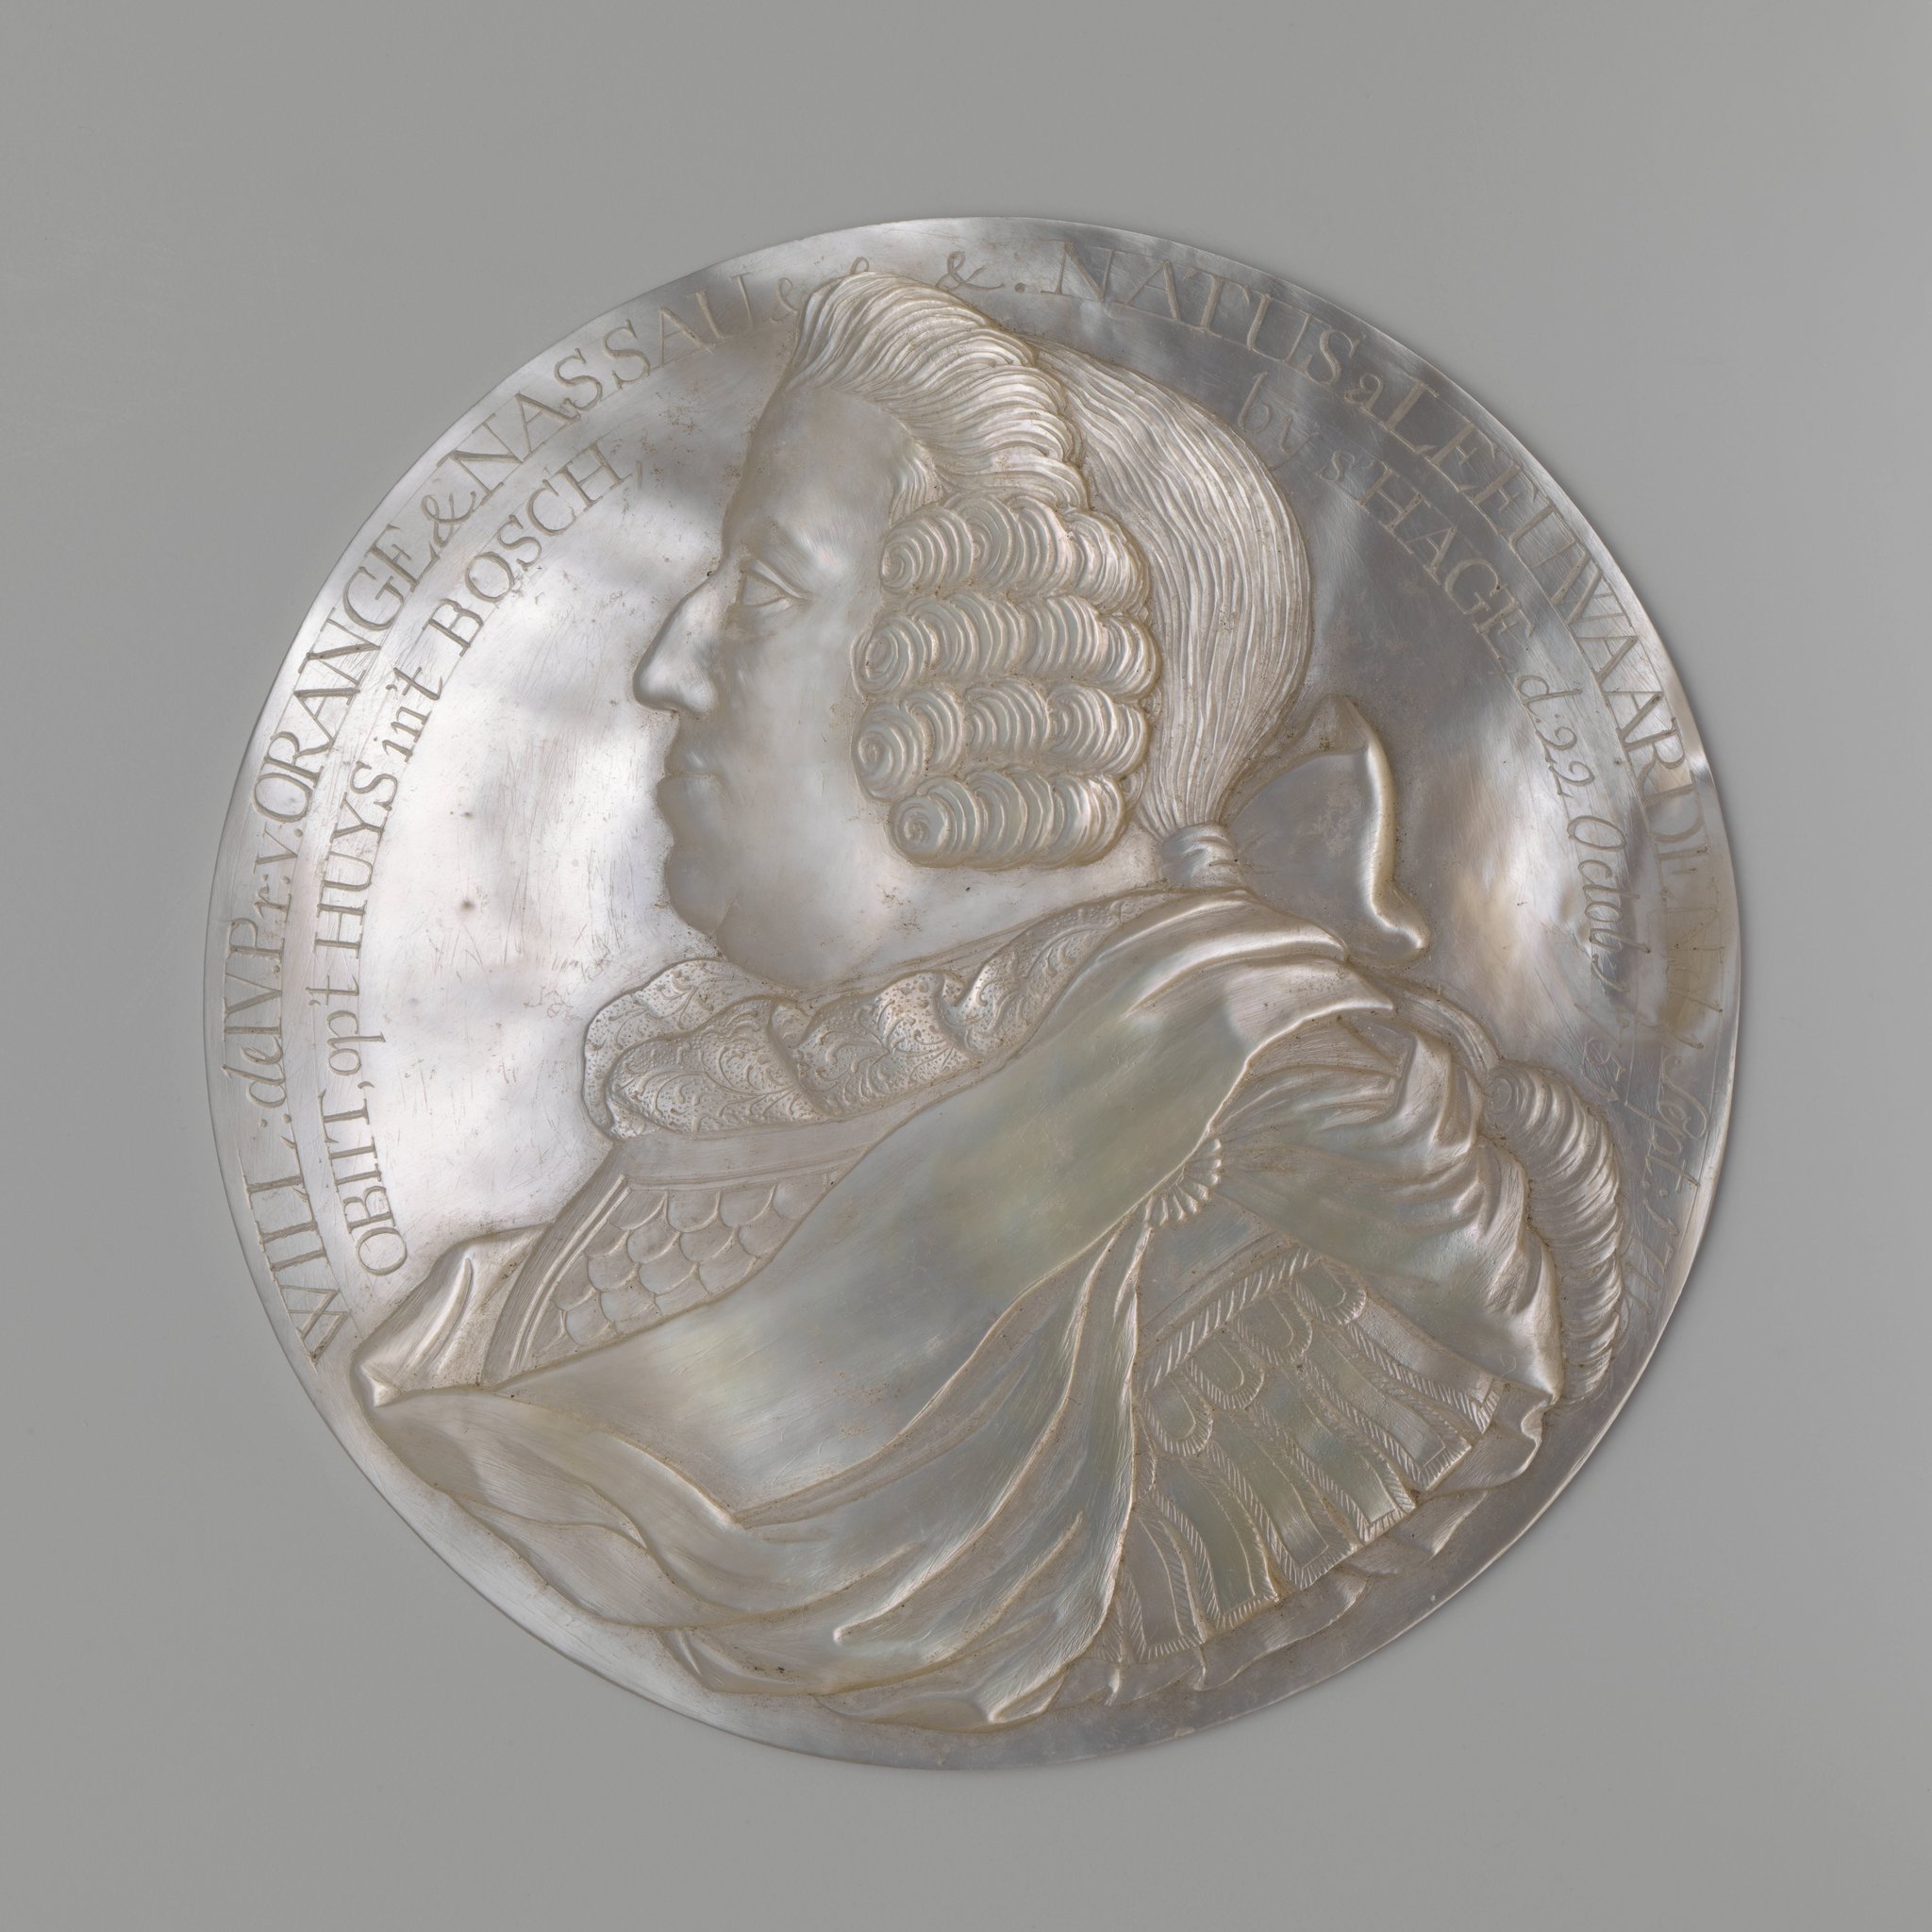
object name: portretmedaillon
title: Medaillonportret, prins Willem IV van Oranje-Nassau (1711-1751)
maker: johannes christiaan konsé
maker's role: jeweler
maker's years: 1700-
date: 1756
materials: mother of pearl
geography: amsterdam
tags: the hague, willem iv (prins van oranje-nassau)